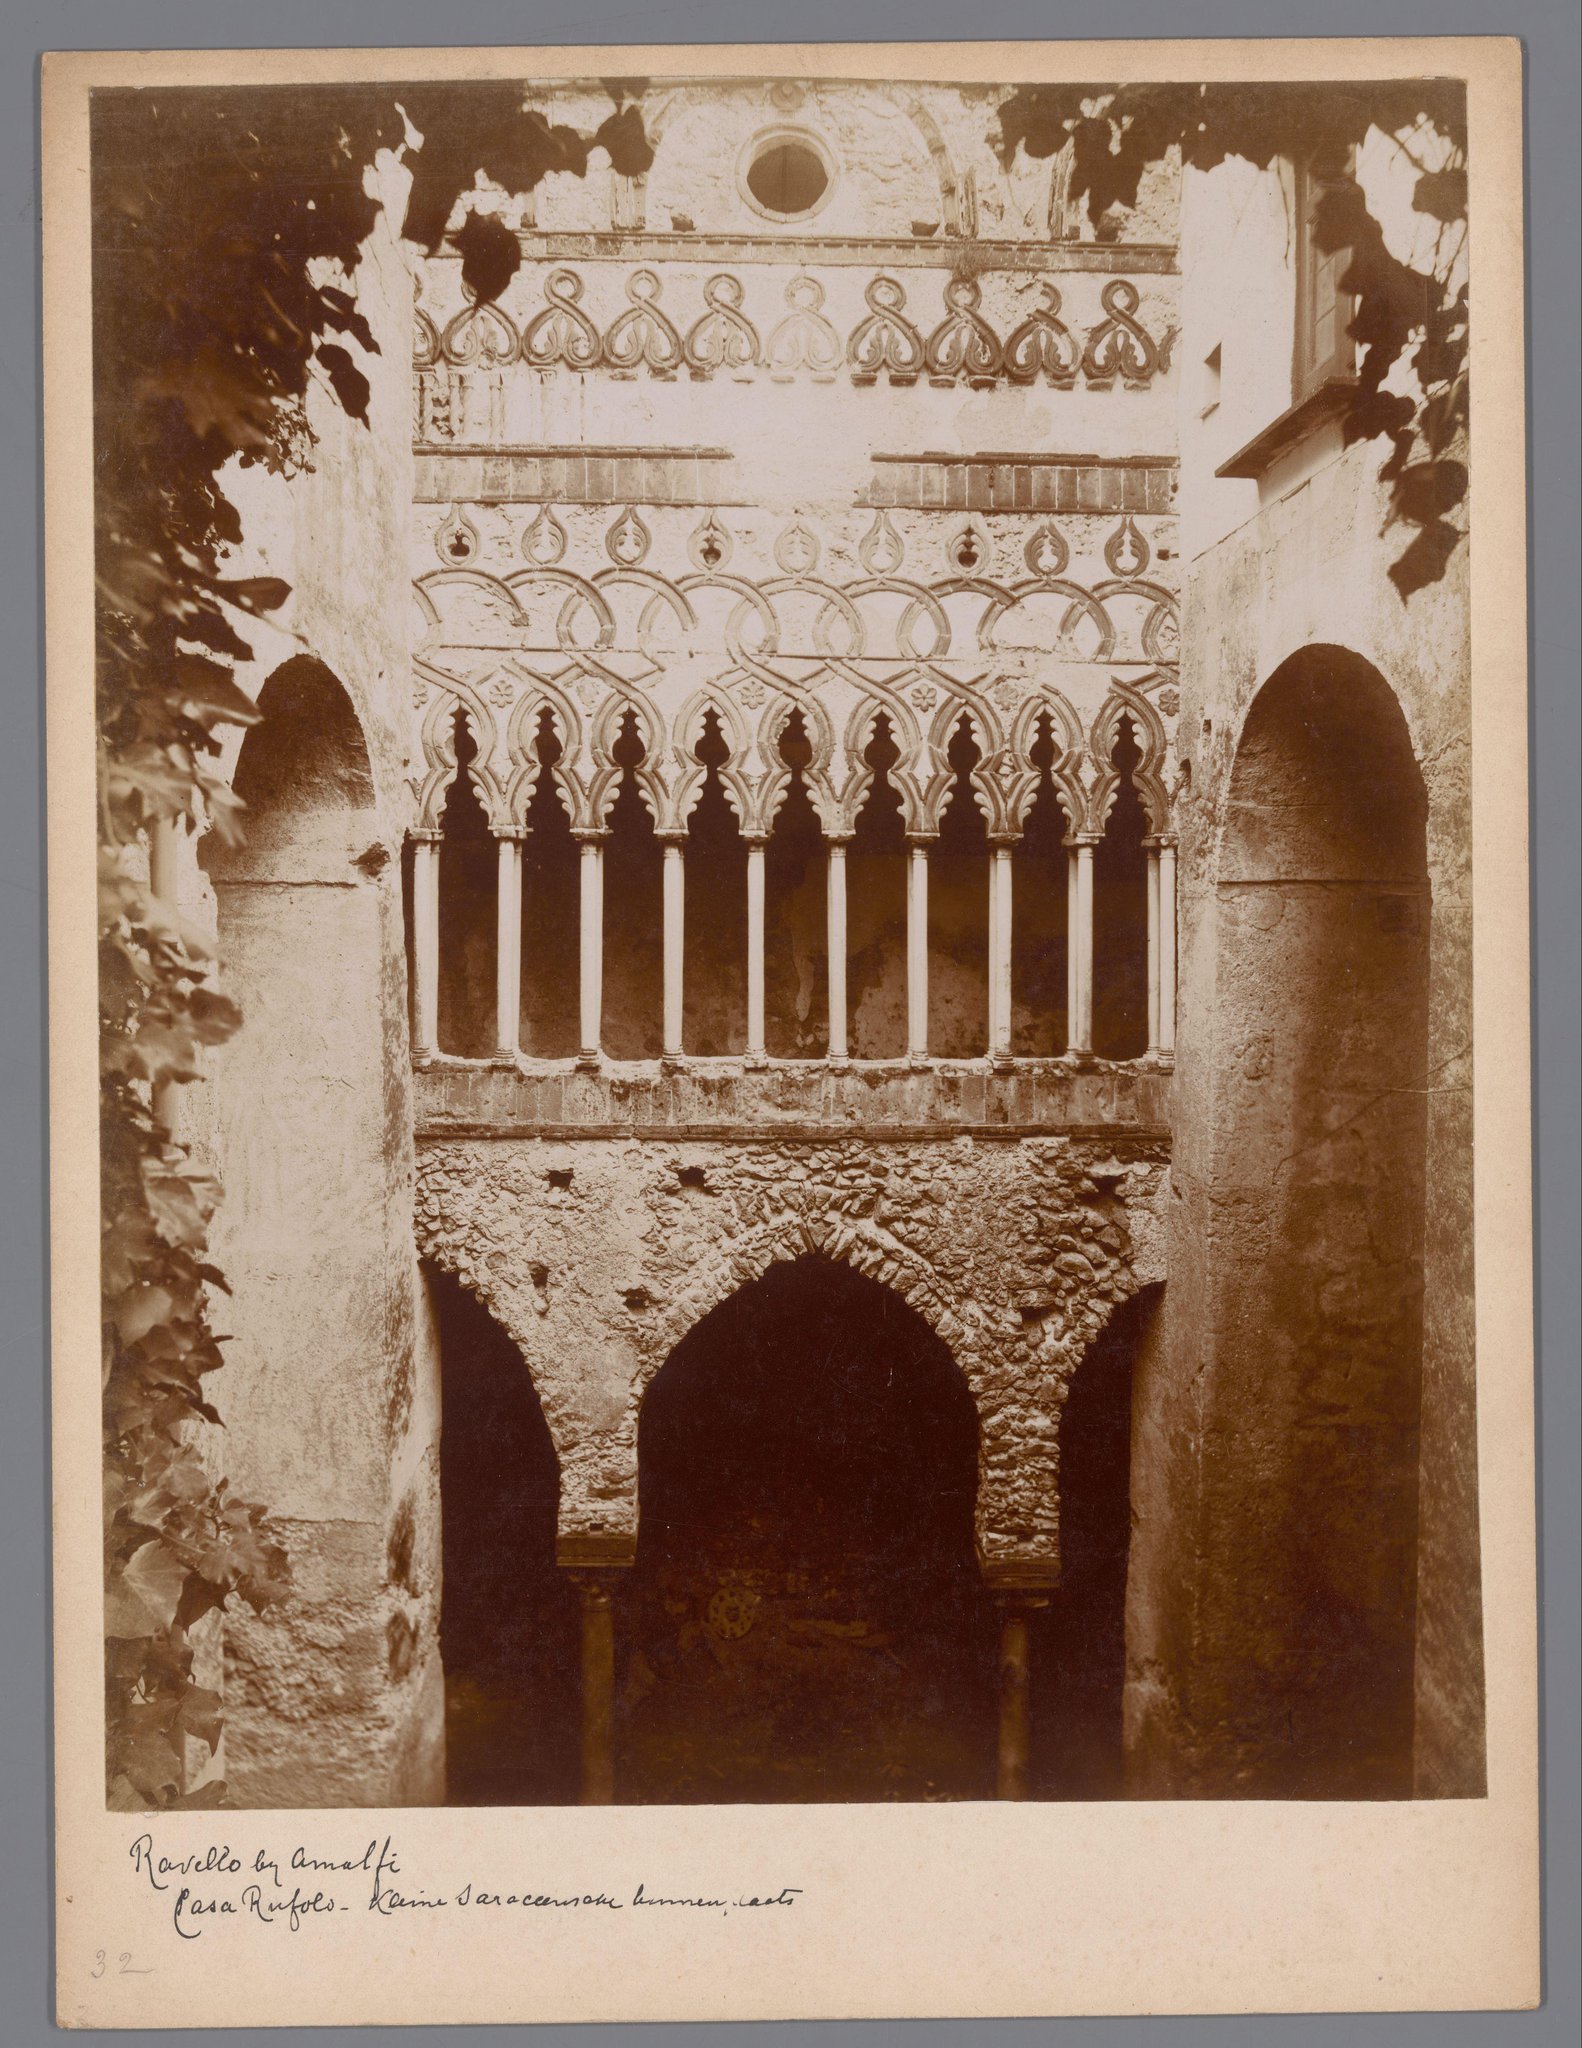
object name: photograph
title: Binnenplaats van de Villa Rufolo te Ravello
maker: Anonymous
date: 1851-1900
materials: cardboard, paper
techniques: albumen print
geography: ravello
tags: courtyard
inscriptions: number: ‘32’